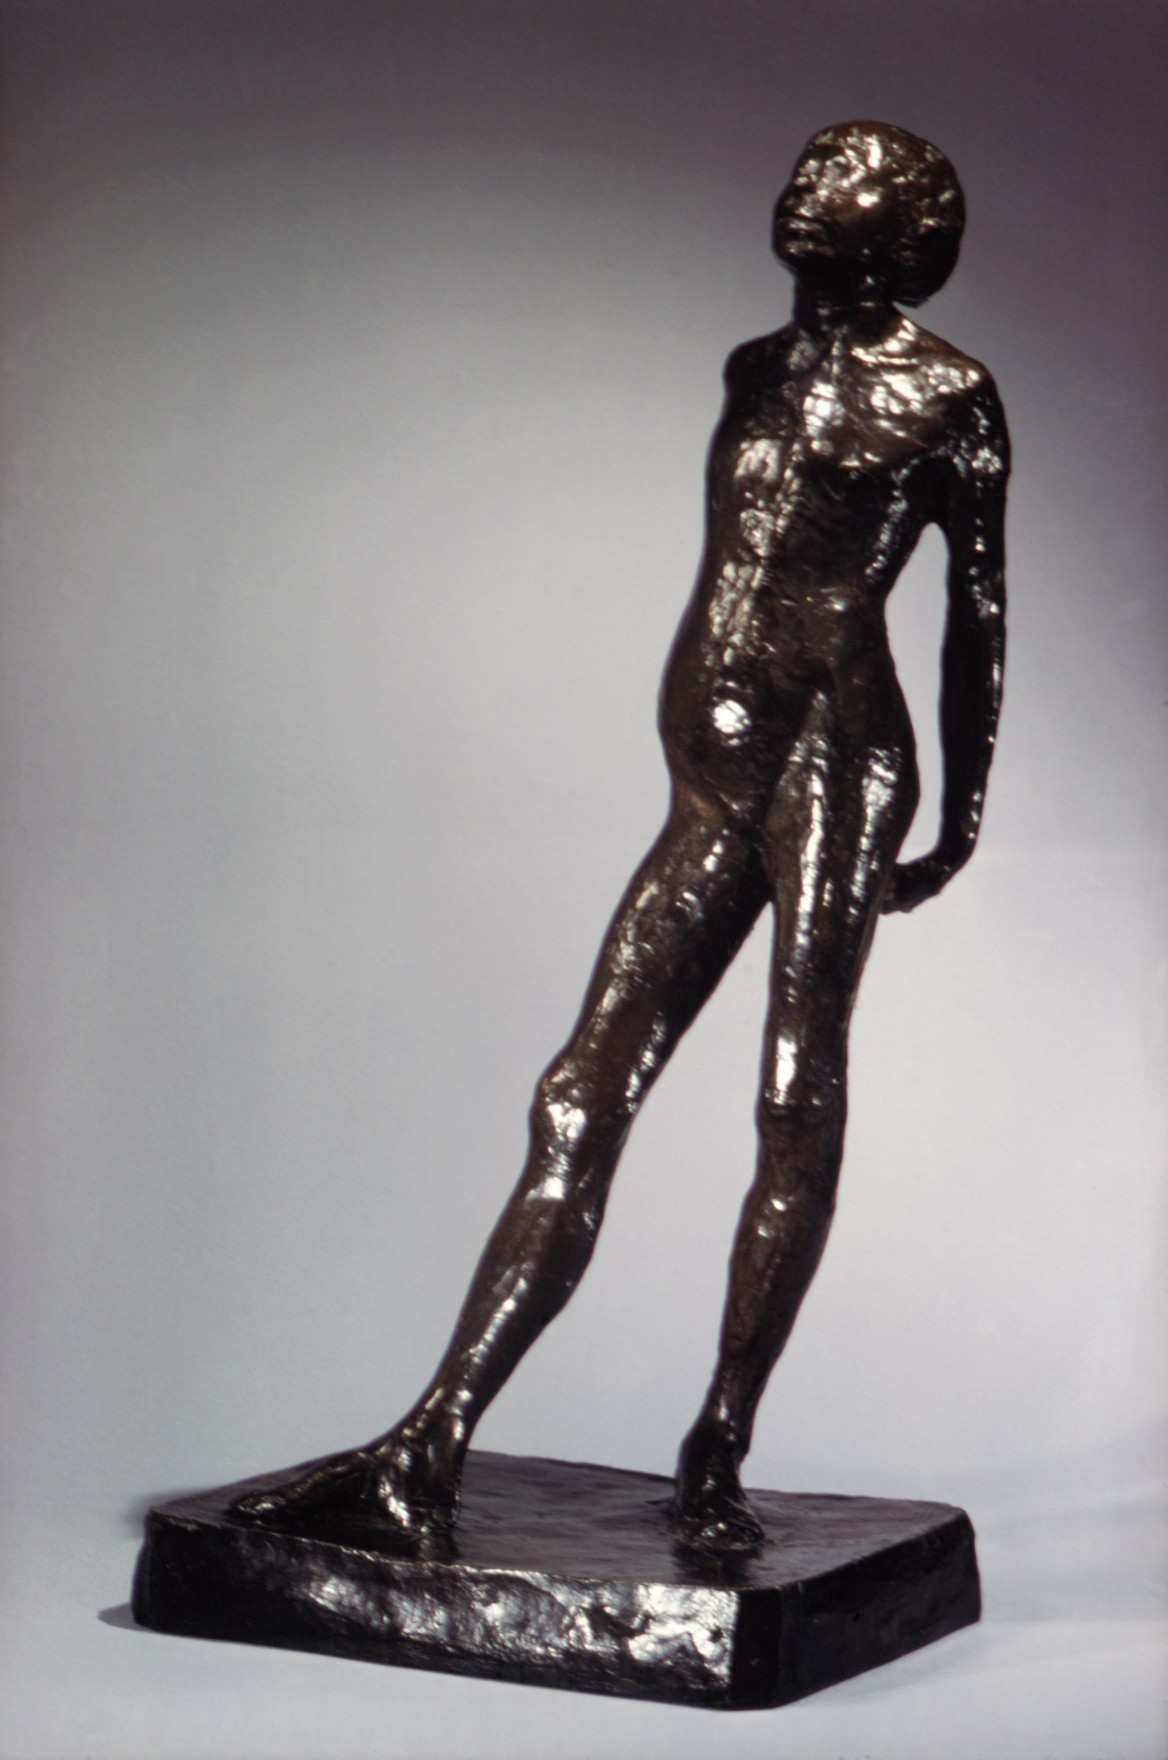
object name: statue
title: Study in the Nude for The Little Fourteen-Year-Old Dancer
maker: edgar degas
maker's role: artist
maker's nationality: french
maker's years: 1834-1917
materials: bronze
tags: dancers